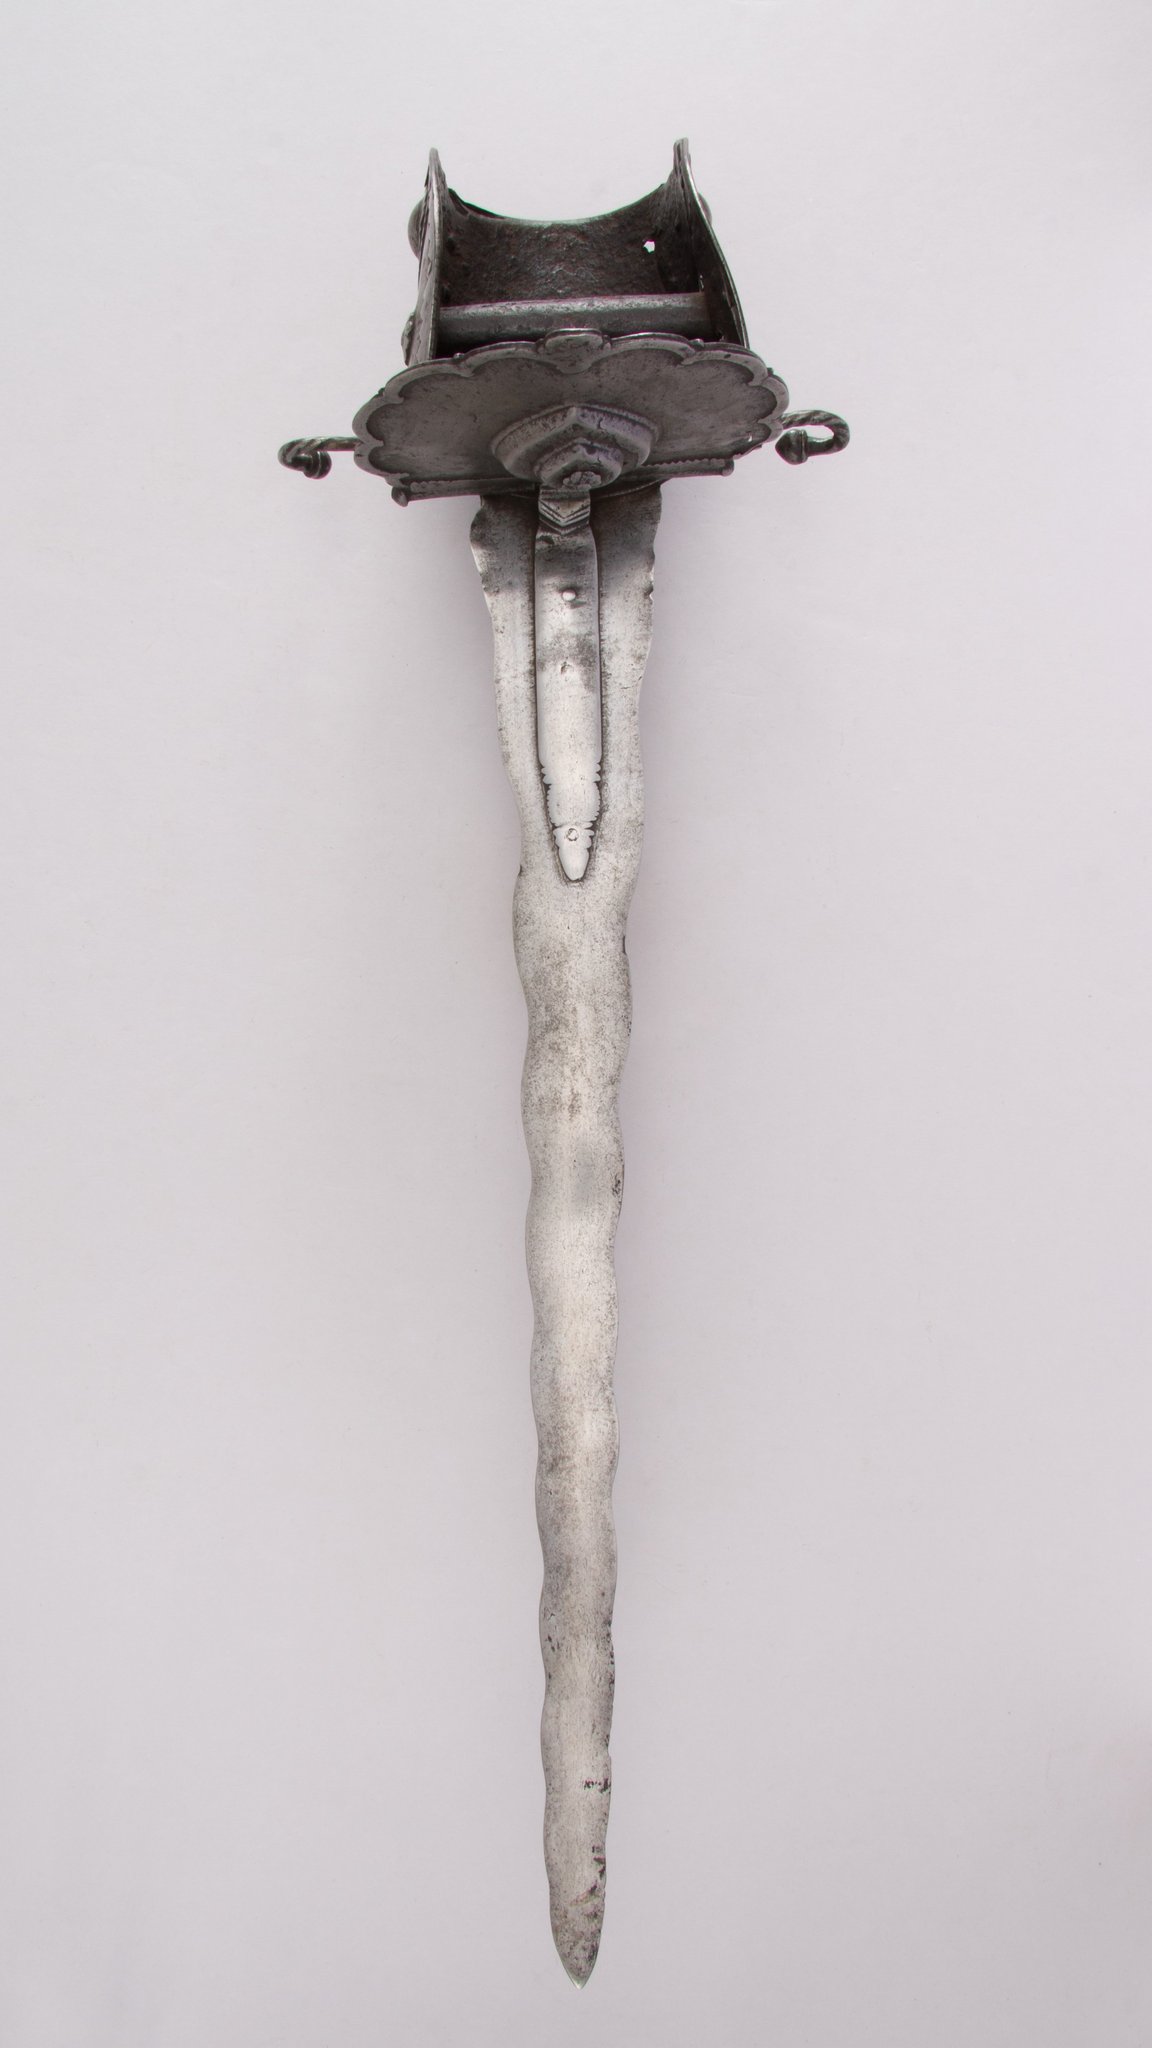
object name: gauntlet dagger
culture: indian, south indian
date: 1801-1900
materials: steel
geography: south india